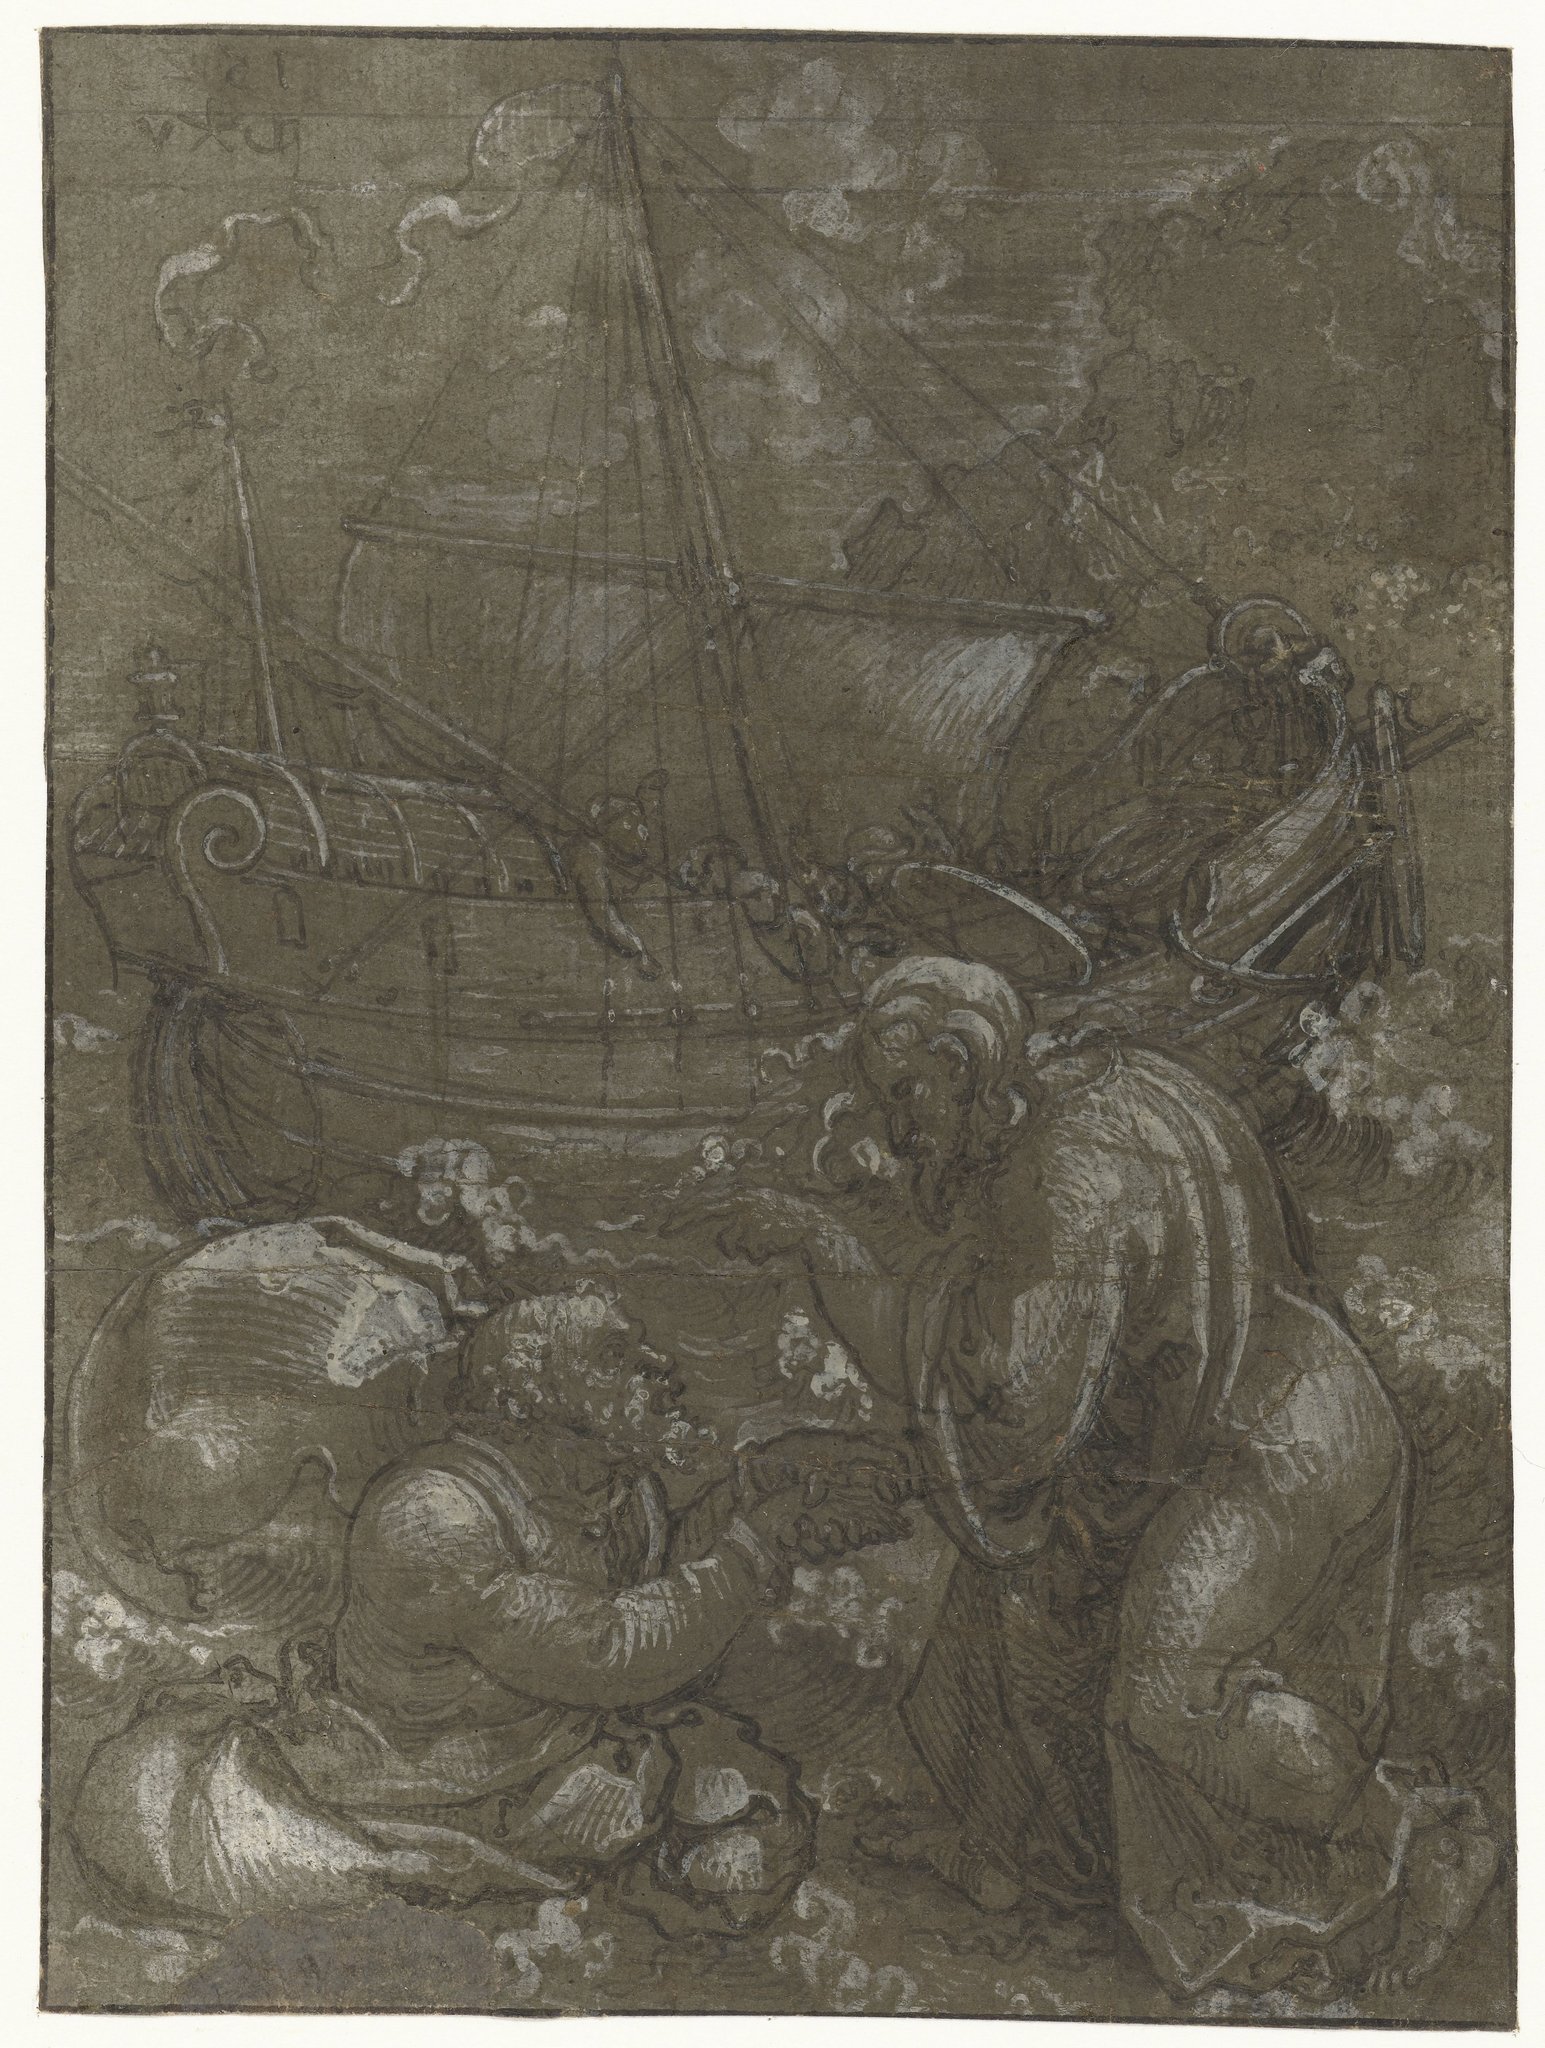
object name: design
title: Redding van Petrus door Christus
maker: dirck vellert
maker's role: draughtsman, painter, print maker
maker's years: 1480-1547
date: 1525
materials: ink, paint, paper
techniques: pen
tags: christ saves peter from drowning